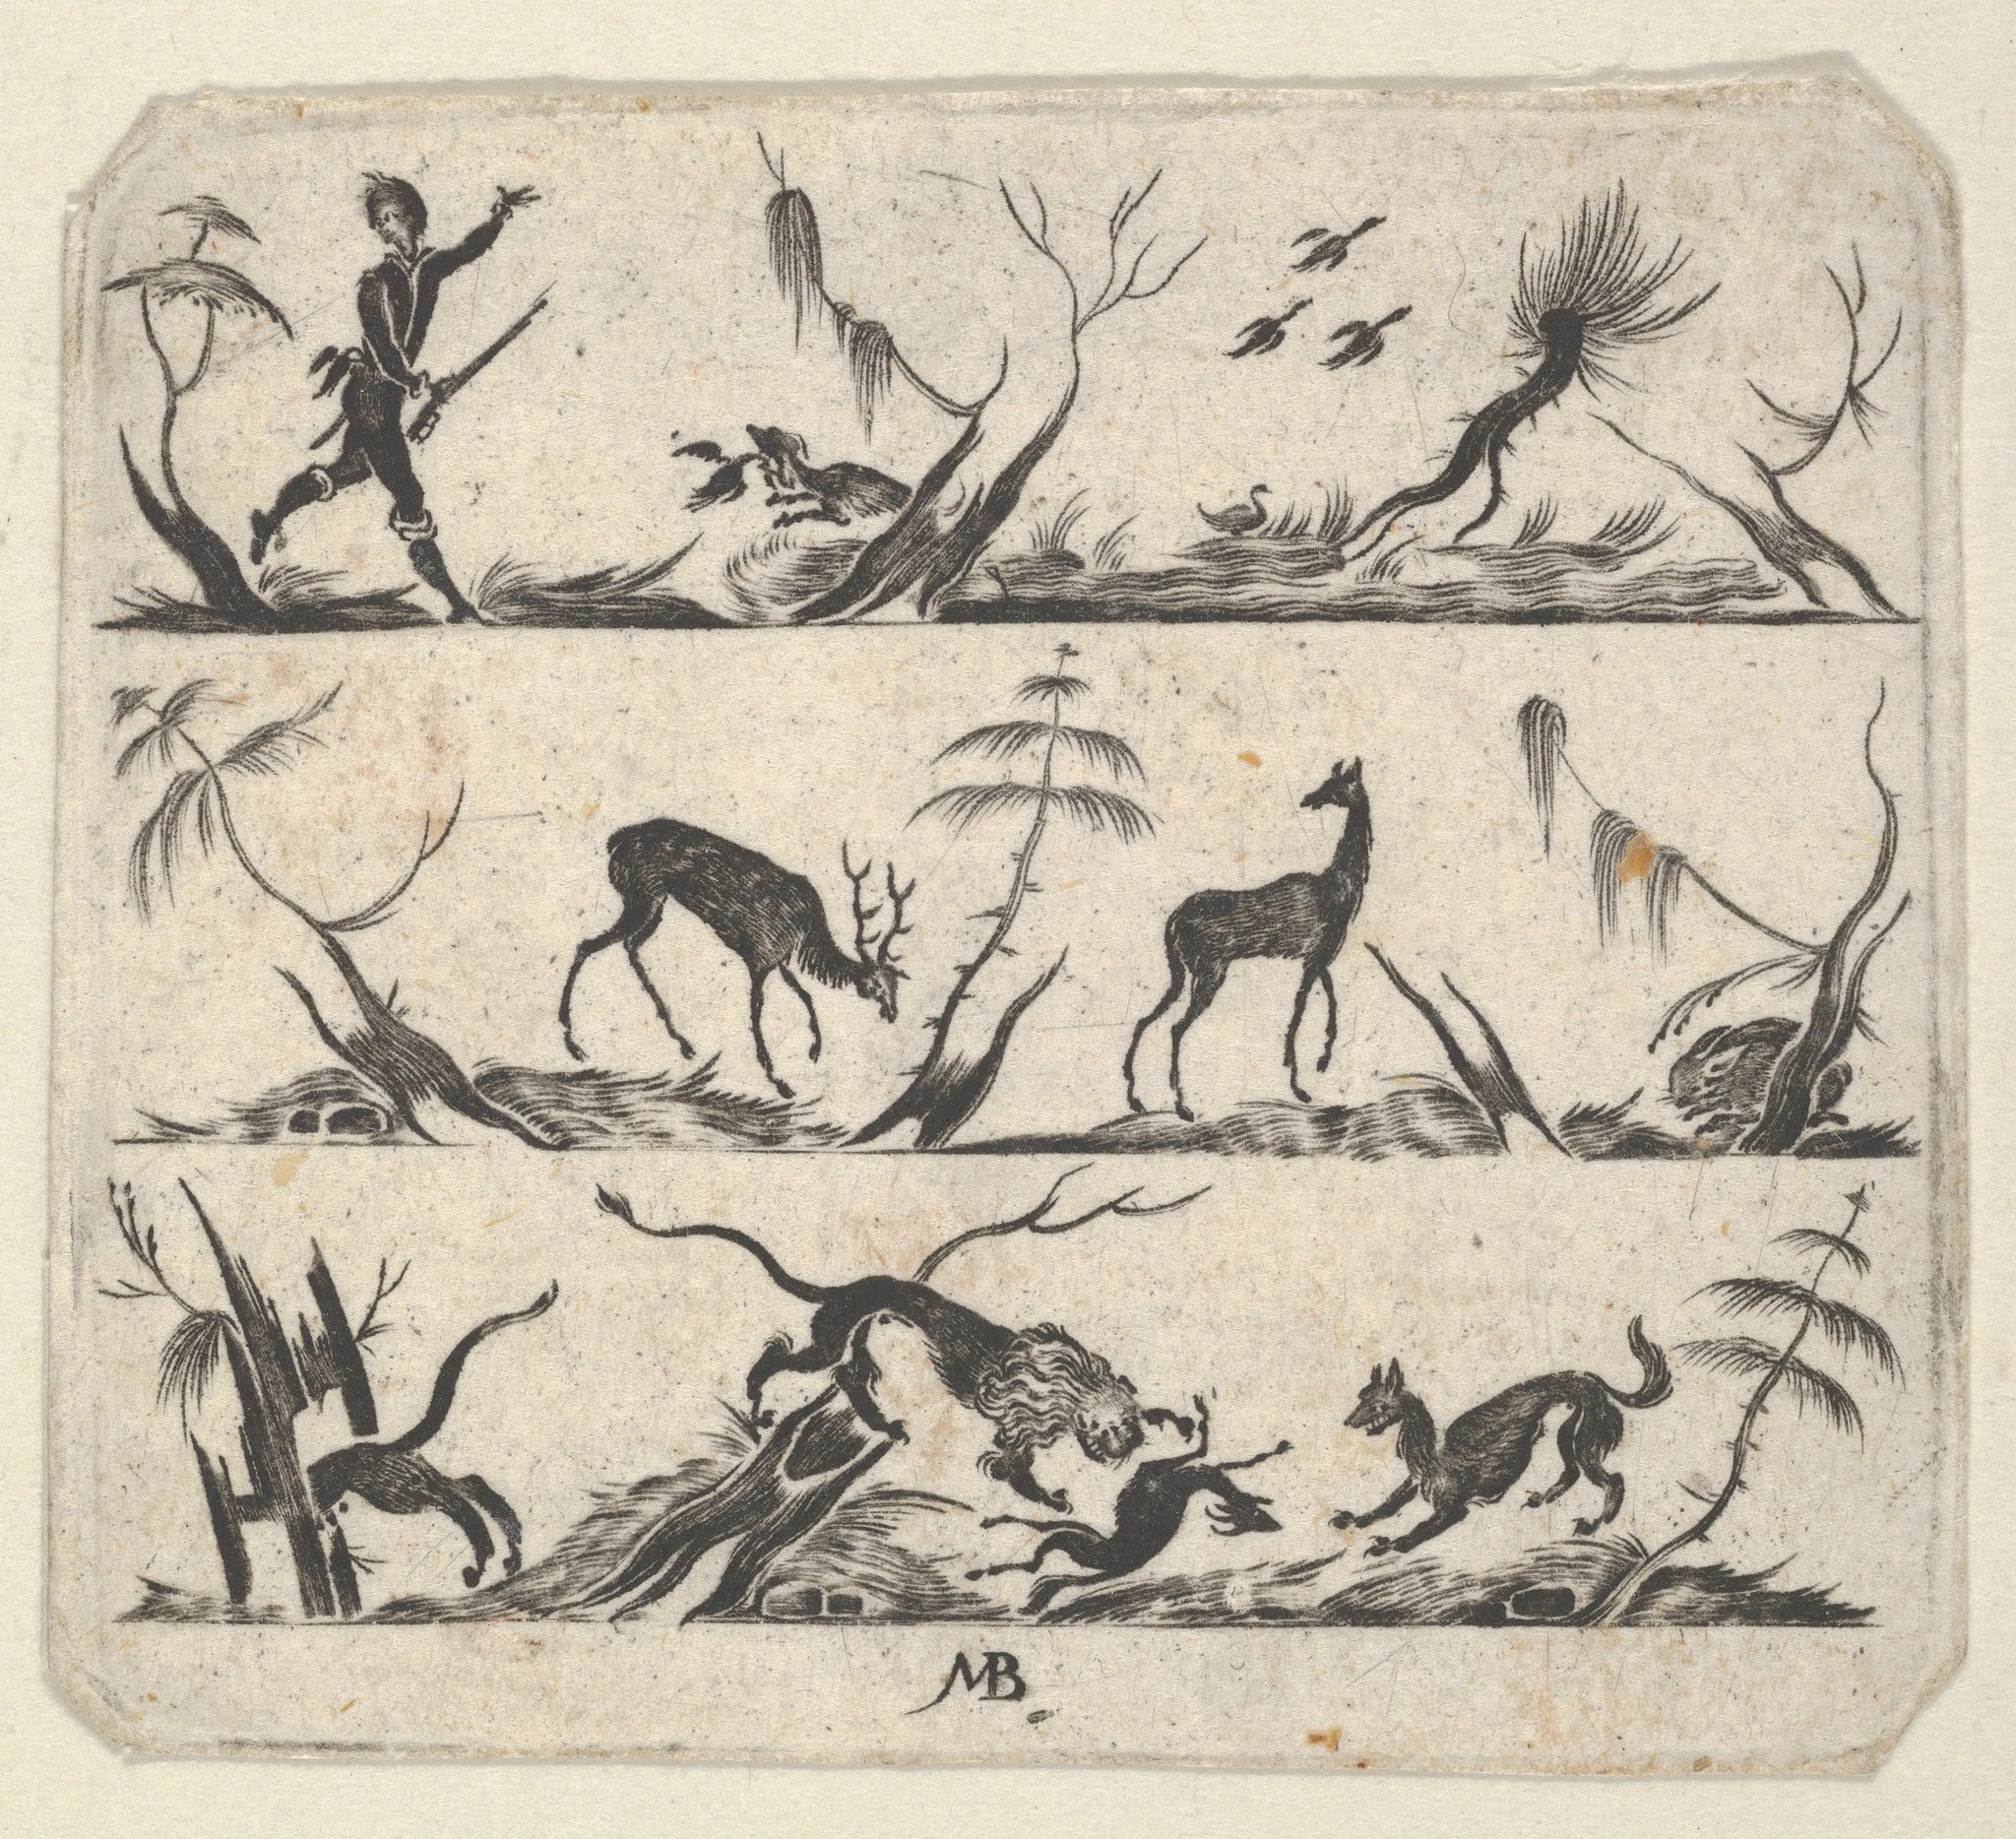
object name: print ornament architecture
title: Blackwork Design for Goldsmithwork with a Hunter and Animals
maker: mathais beitler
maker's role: artist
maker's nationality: german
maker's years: 1582-1616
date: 1612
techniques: embroidery, engraving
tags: animals,hunting,deer